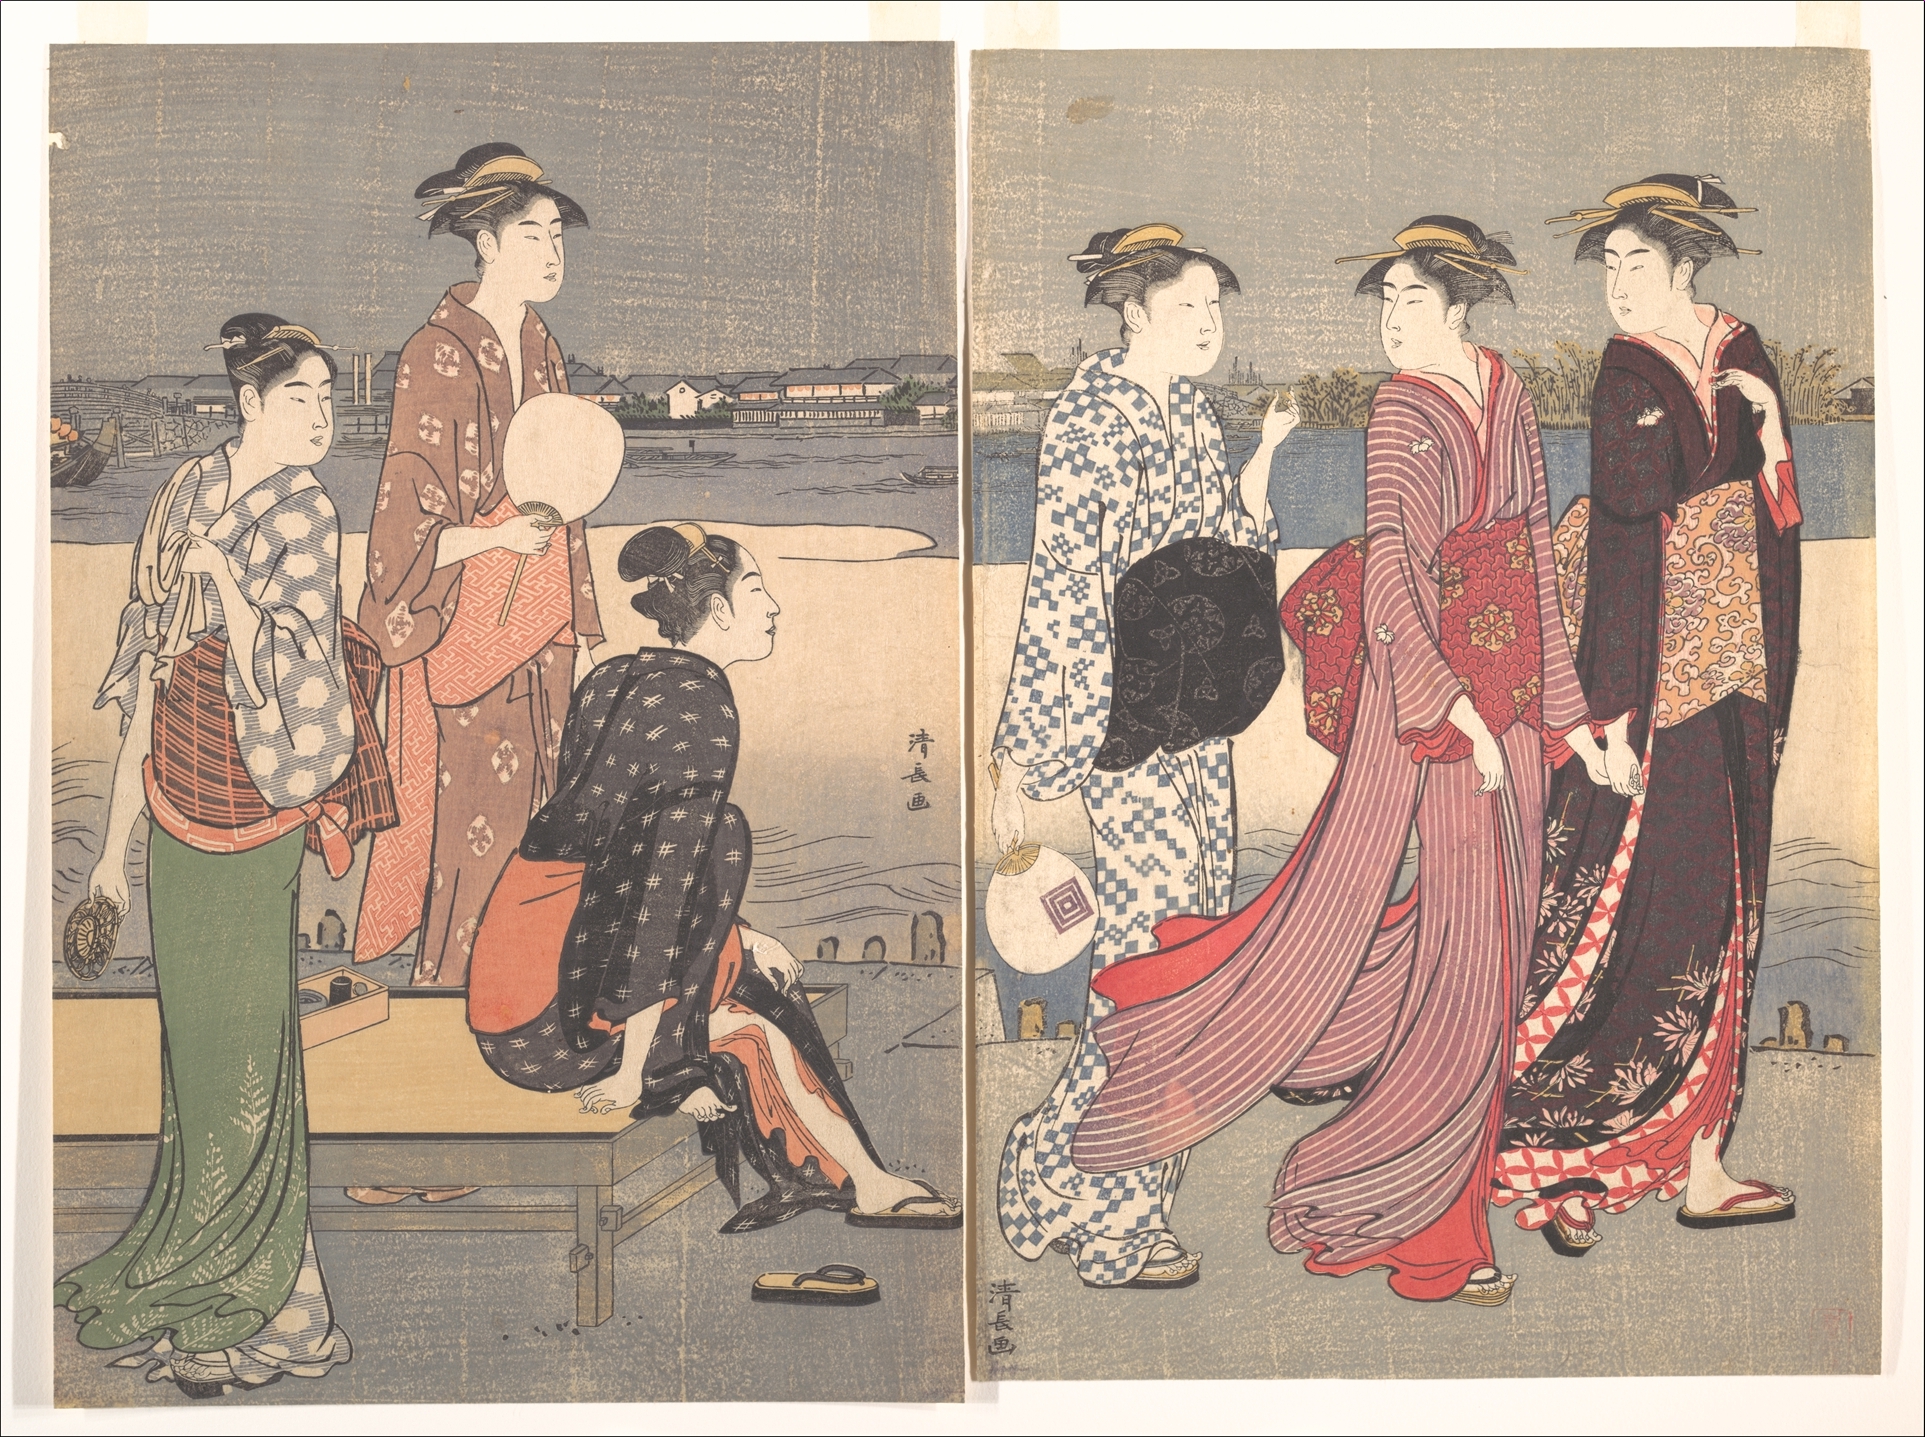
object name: print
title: Enjoying the Evening Cool on the Banks of the Sumida River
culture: japanese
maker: torii kiyonaga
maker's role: artist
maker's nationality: japanese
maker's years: 1752-1815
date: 1784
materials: ink, paper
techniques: nishiki e, woodblock print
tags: fans,women,rivers